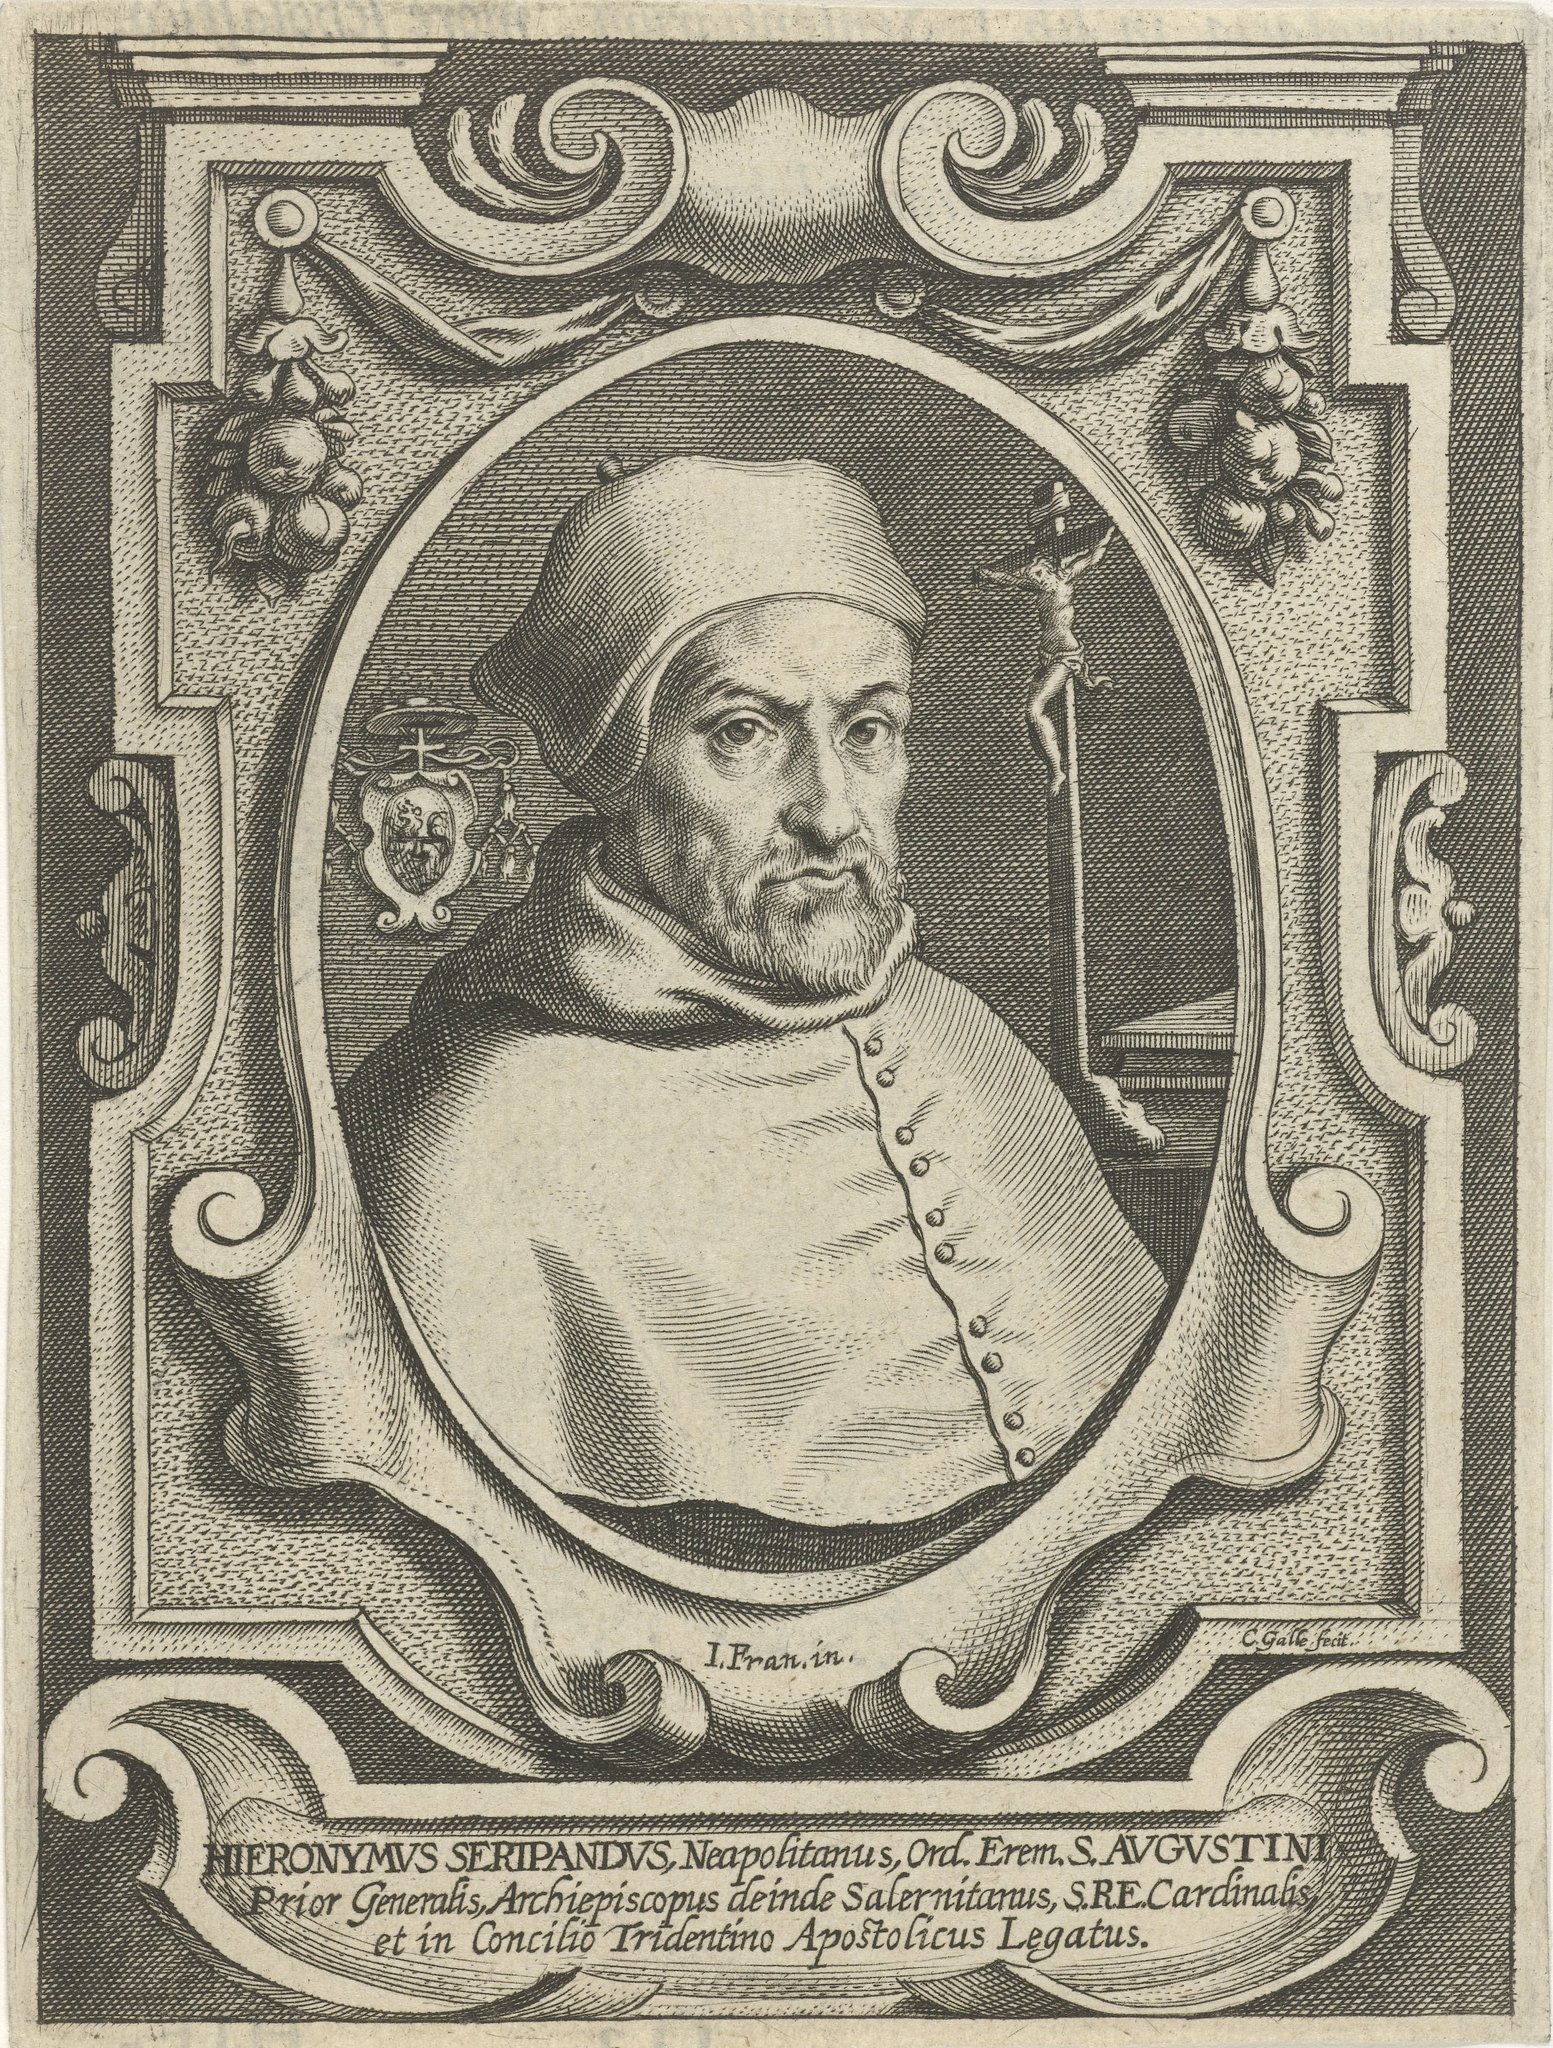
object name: book illustration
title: Portret van de Augustijn en kardinaal Girolamo Seripando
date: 1636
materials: paper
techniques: engraving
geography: southern netherlands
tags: monastic orders, monastic life ~ roman catholic church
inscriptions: collector's mark: Lugt 2228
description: Boekillustratie voor: C. Curtius, Virorum illustrium ex ordine Eremitarum D. Augustini elogia , Antwerpen: J. Cnobbaert, 1636.